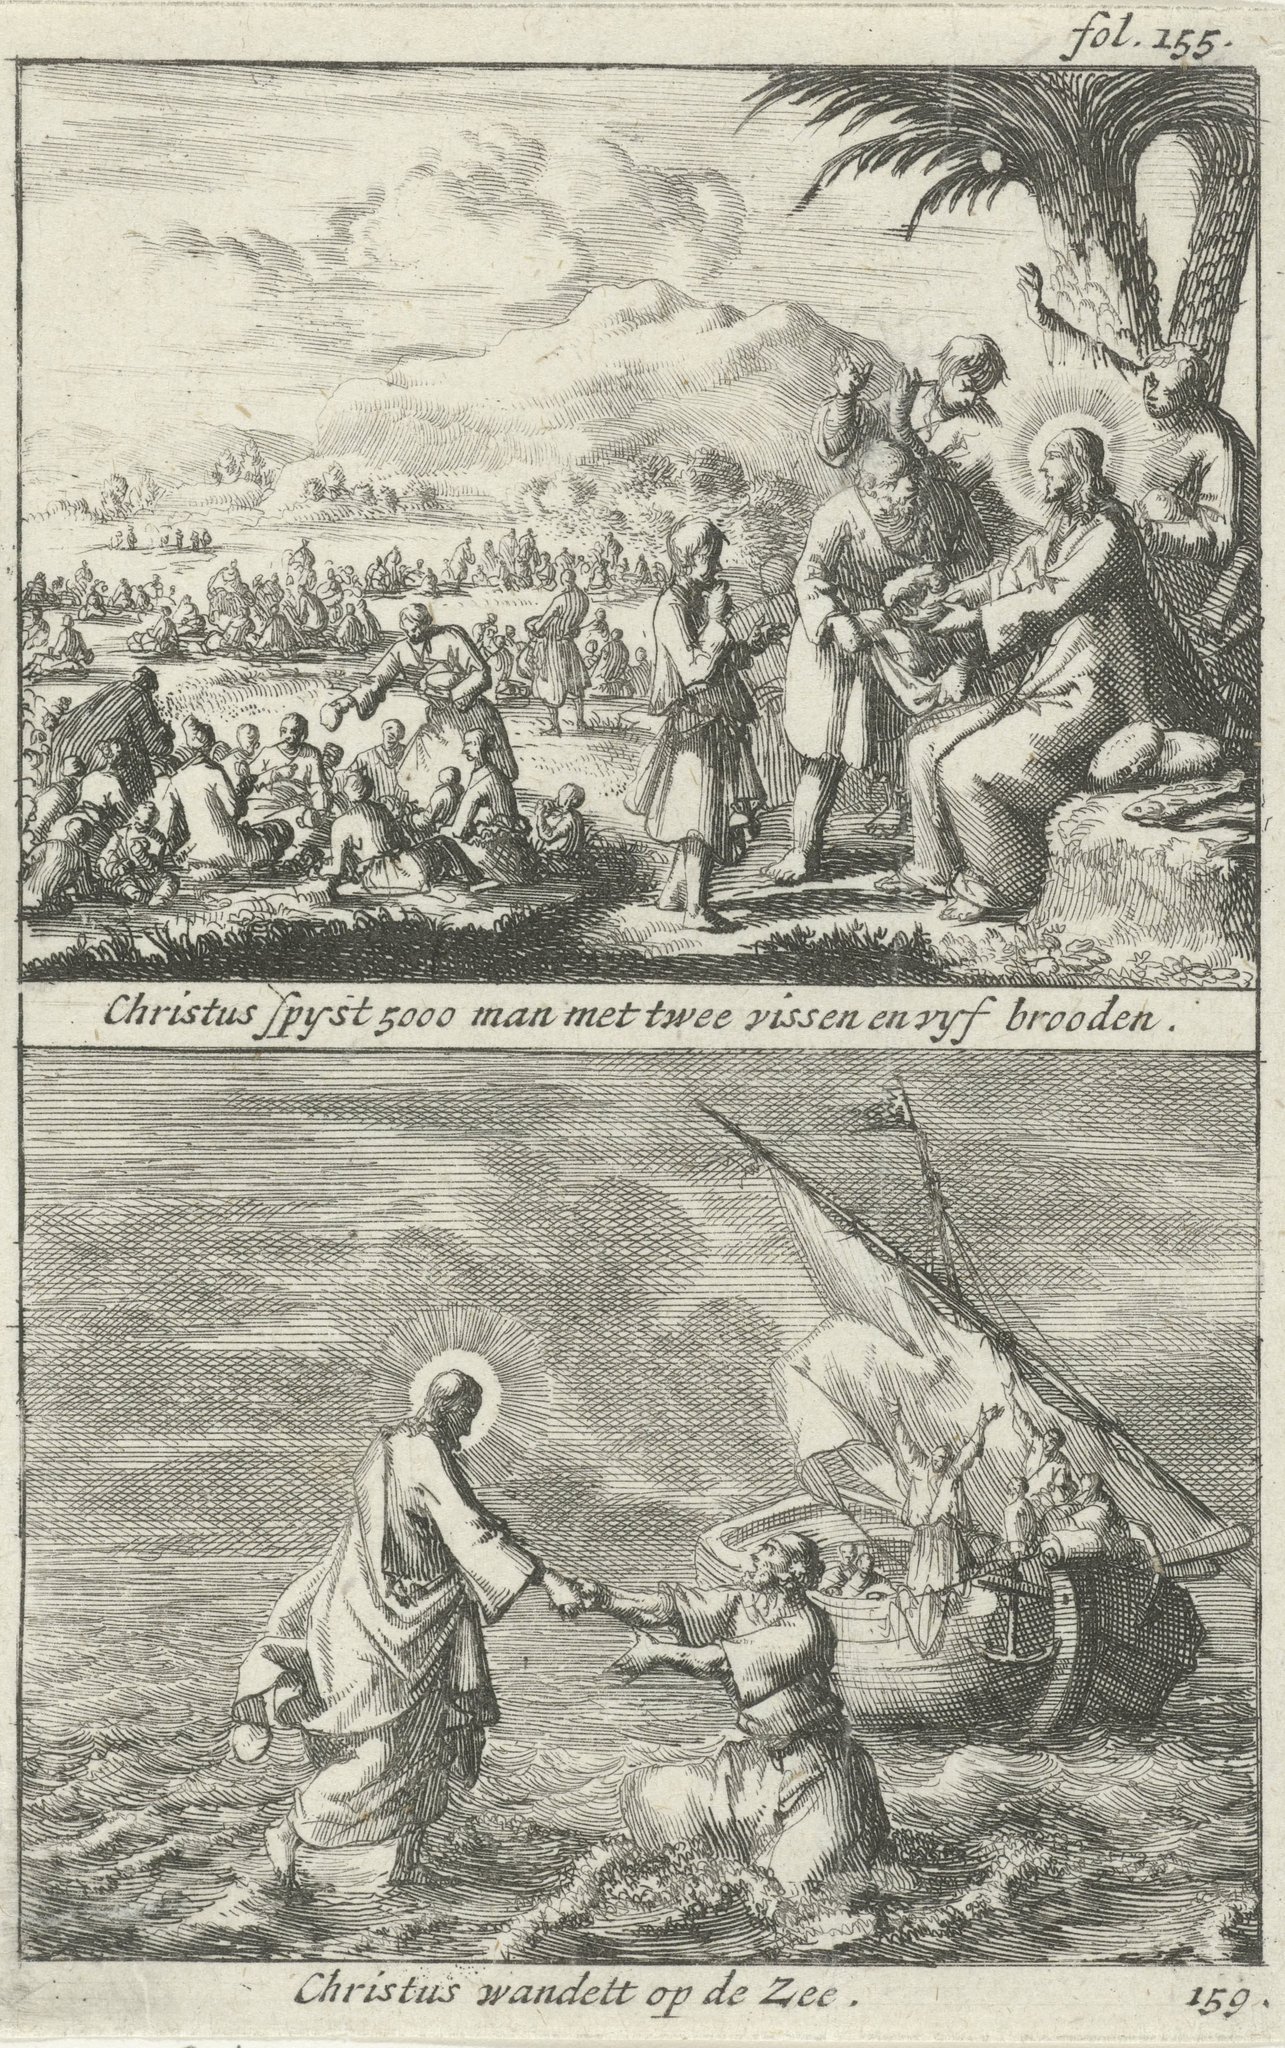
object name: print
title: Wonderbaarlijke vermenigvuldiging van broden en vissen door Christus en Christus loopt over het water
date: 1690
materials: paper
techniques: etching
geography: amsterdam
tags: multiplication of loaves and fishes for a multitude of four or five thousand people (matthew 14:13-21, 15:32-39; mark 6:32-44, 8:1-10; luke 9:10-17; john 6:1-14), christ saves peter from drowning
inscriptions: collector's mark: Lugt 2228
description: Illustratie uit: Garthwait, Henry. Historie des levens en stervens onses Heeren en saligmakers Jesu Christi. Amsterdam: Jan Claesz ten Hoorn, 1690.